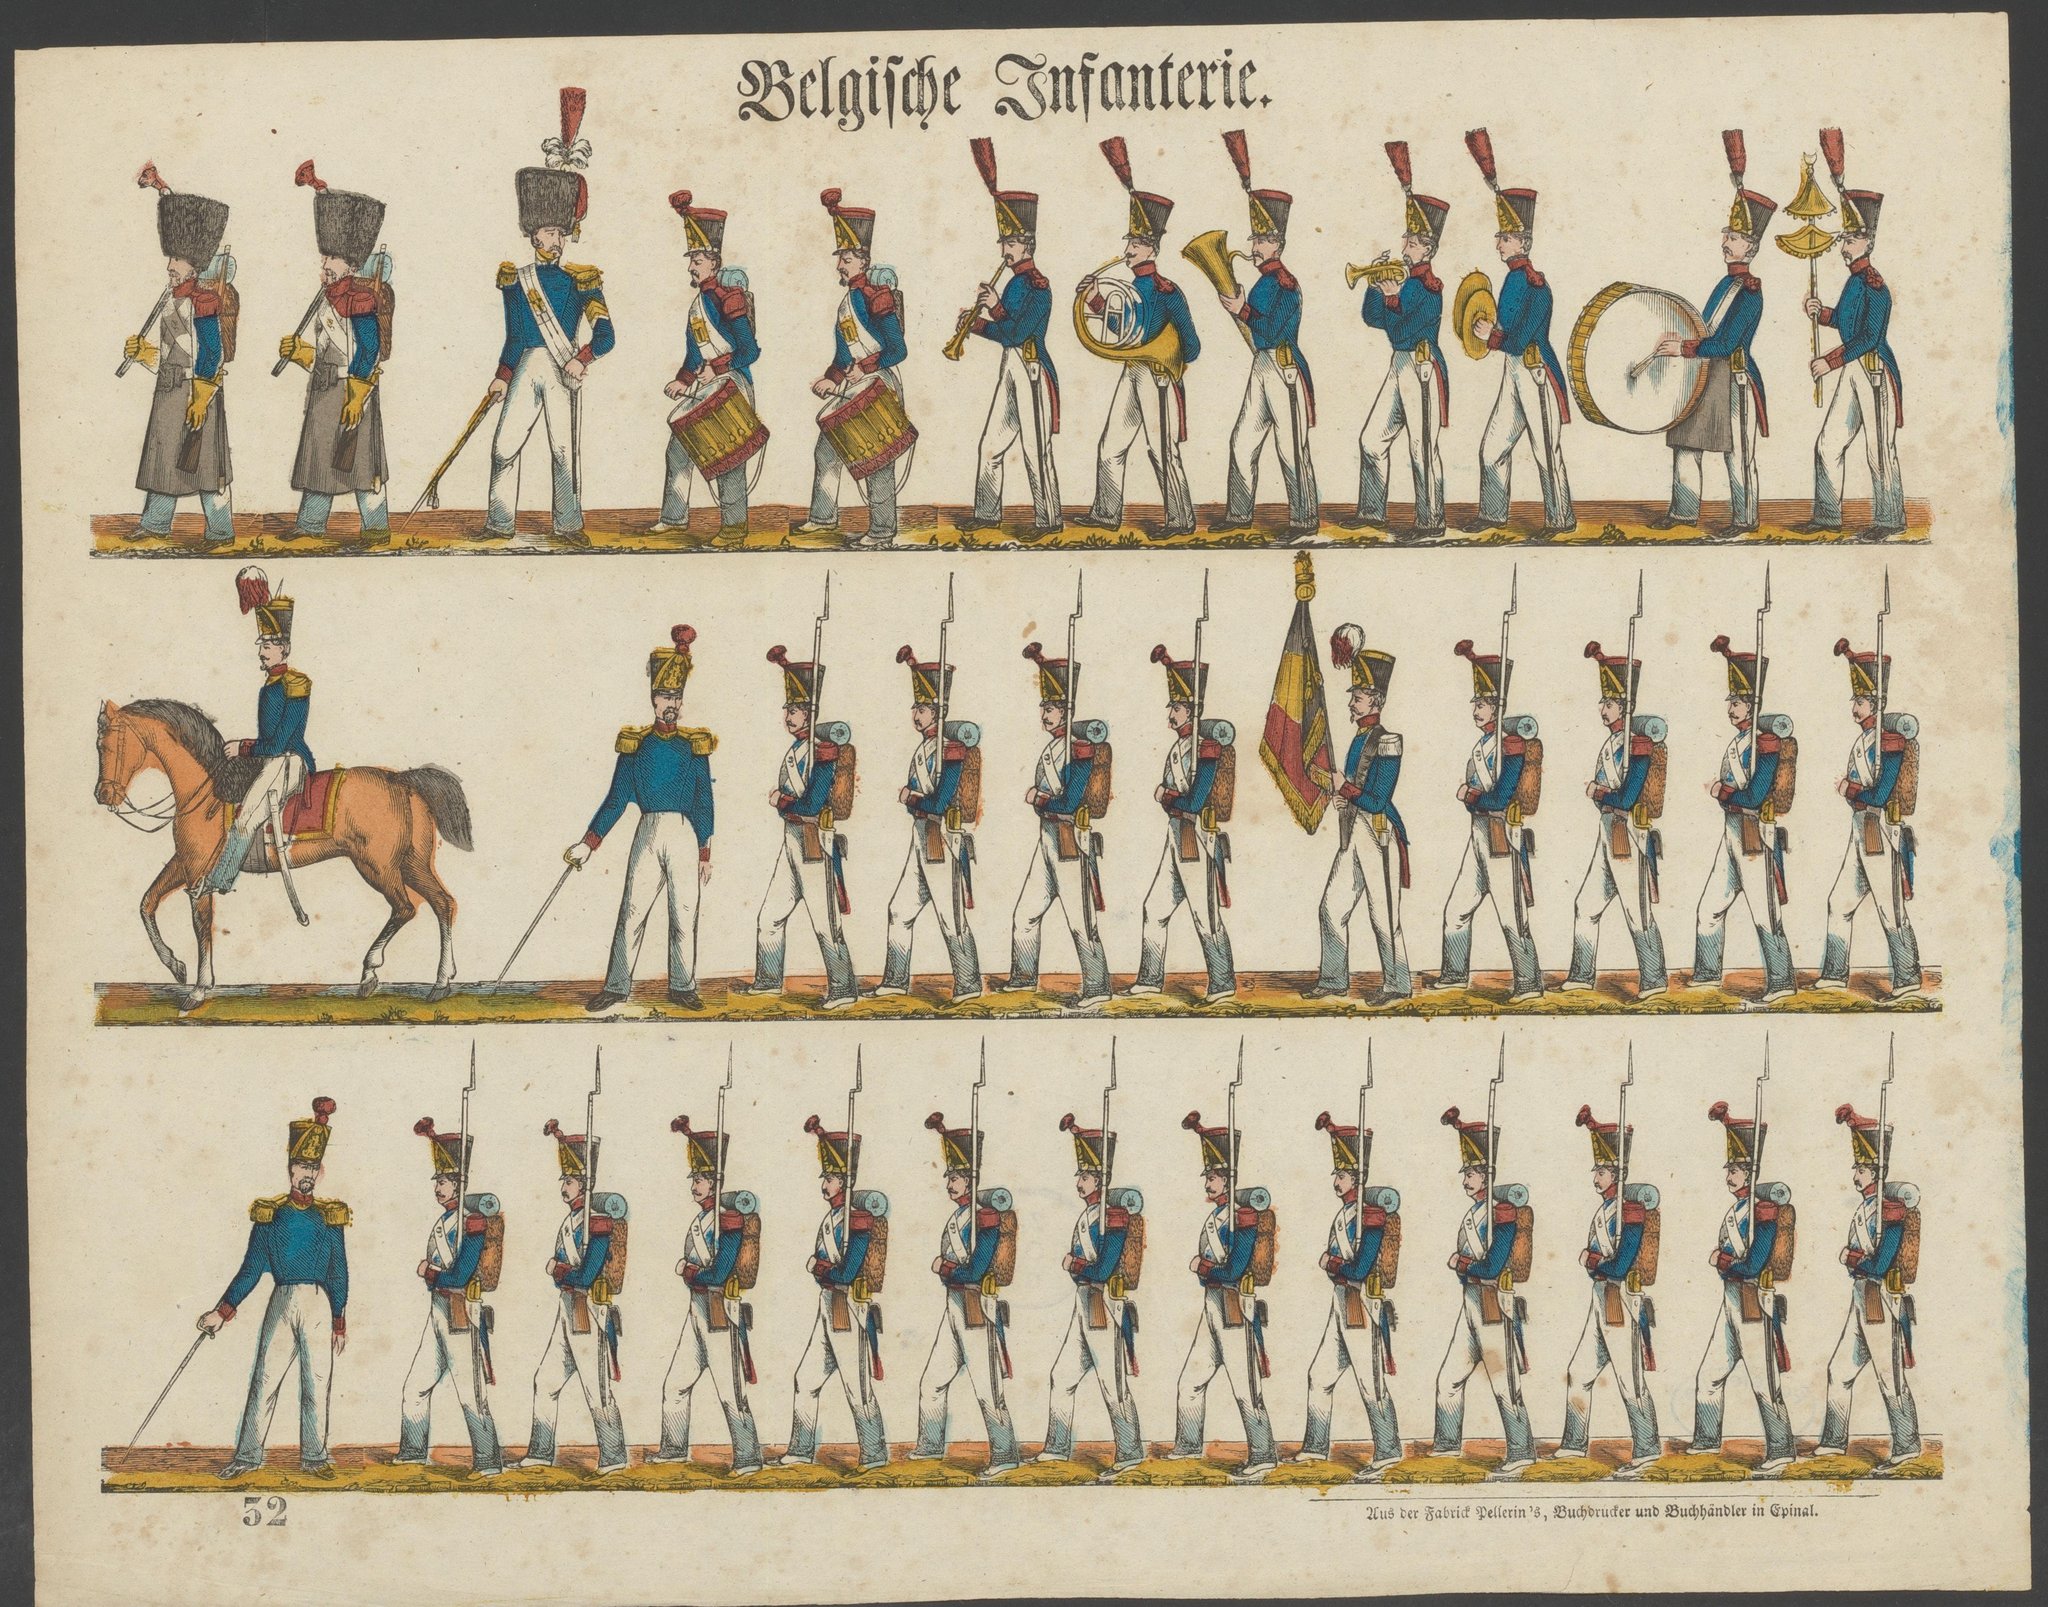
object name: print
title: Belgische Infanterie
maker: Anonymous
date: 1796-1900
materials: paper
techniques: hand coloring, lithograph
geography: epinal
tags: the company, the unit, the troop ~ military service, the soldier; the soldier's life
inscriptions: stamp, collector's mark: Lugt 1641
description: Drie rijen met de Belgische infanterie. Linksonder genummerd: 52. Onderwerpsrubrieken binnen de Atlas Zeden en Gewoonten: Zeden en Gewoonten in Engeren Zin, Des menschen beging, midden en einde, Kinderleven – Kinderspel en Kinderprenten.